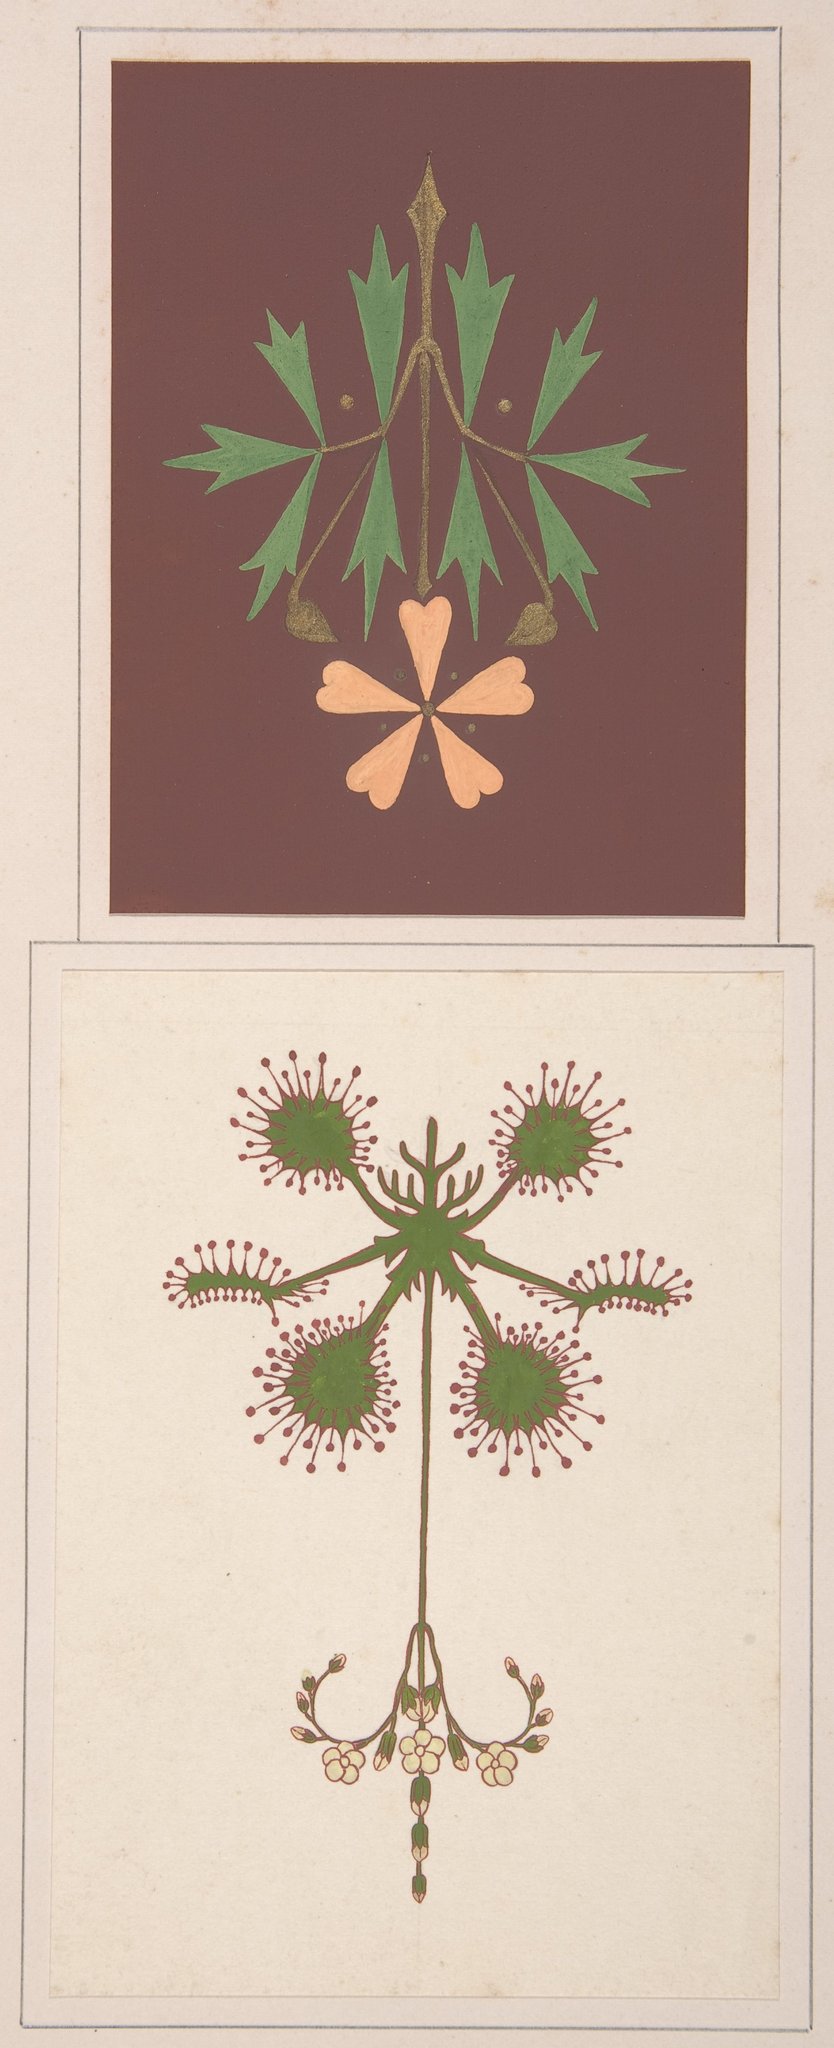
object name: drawing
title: Two design drawings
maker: christopher dresser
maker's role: designer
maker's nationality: british, scottish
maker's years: 1834-1904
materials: gouache, graphite, ink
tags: flowers,leaves